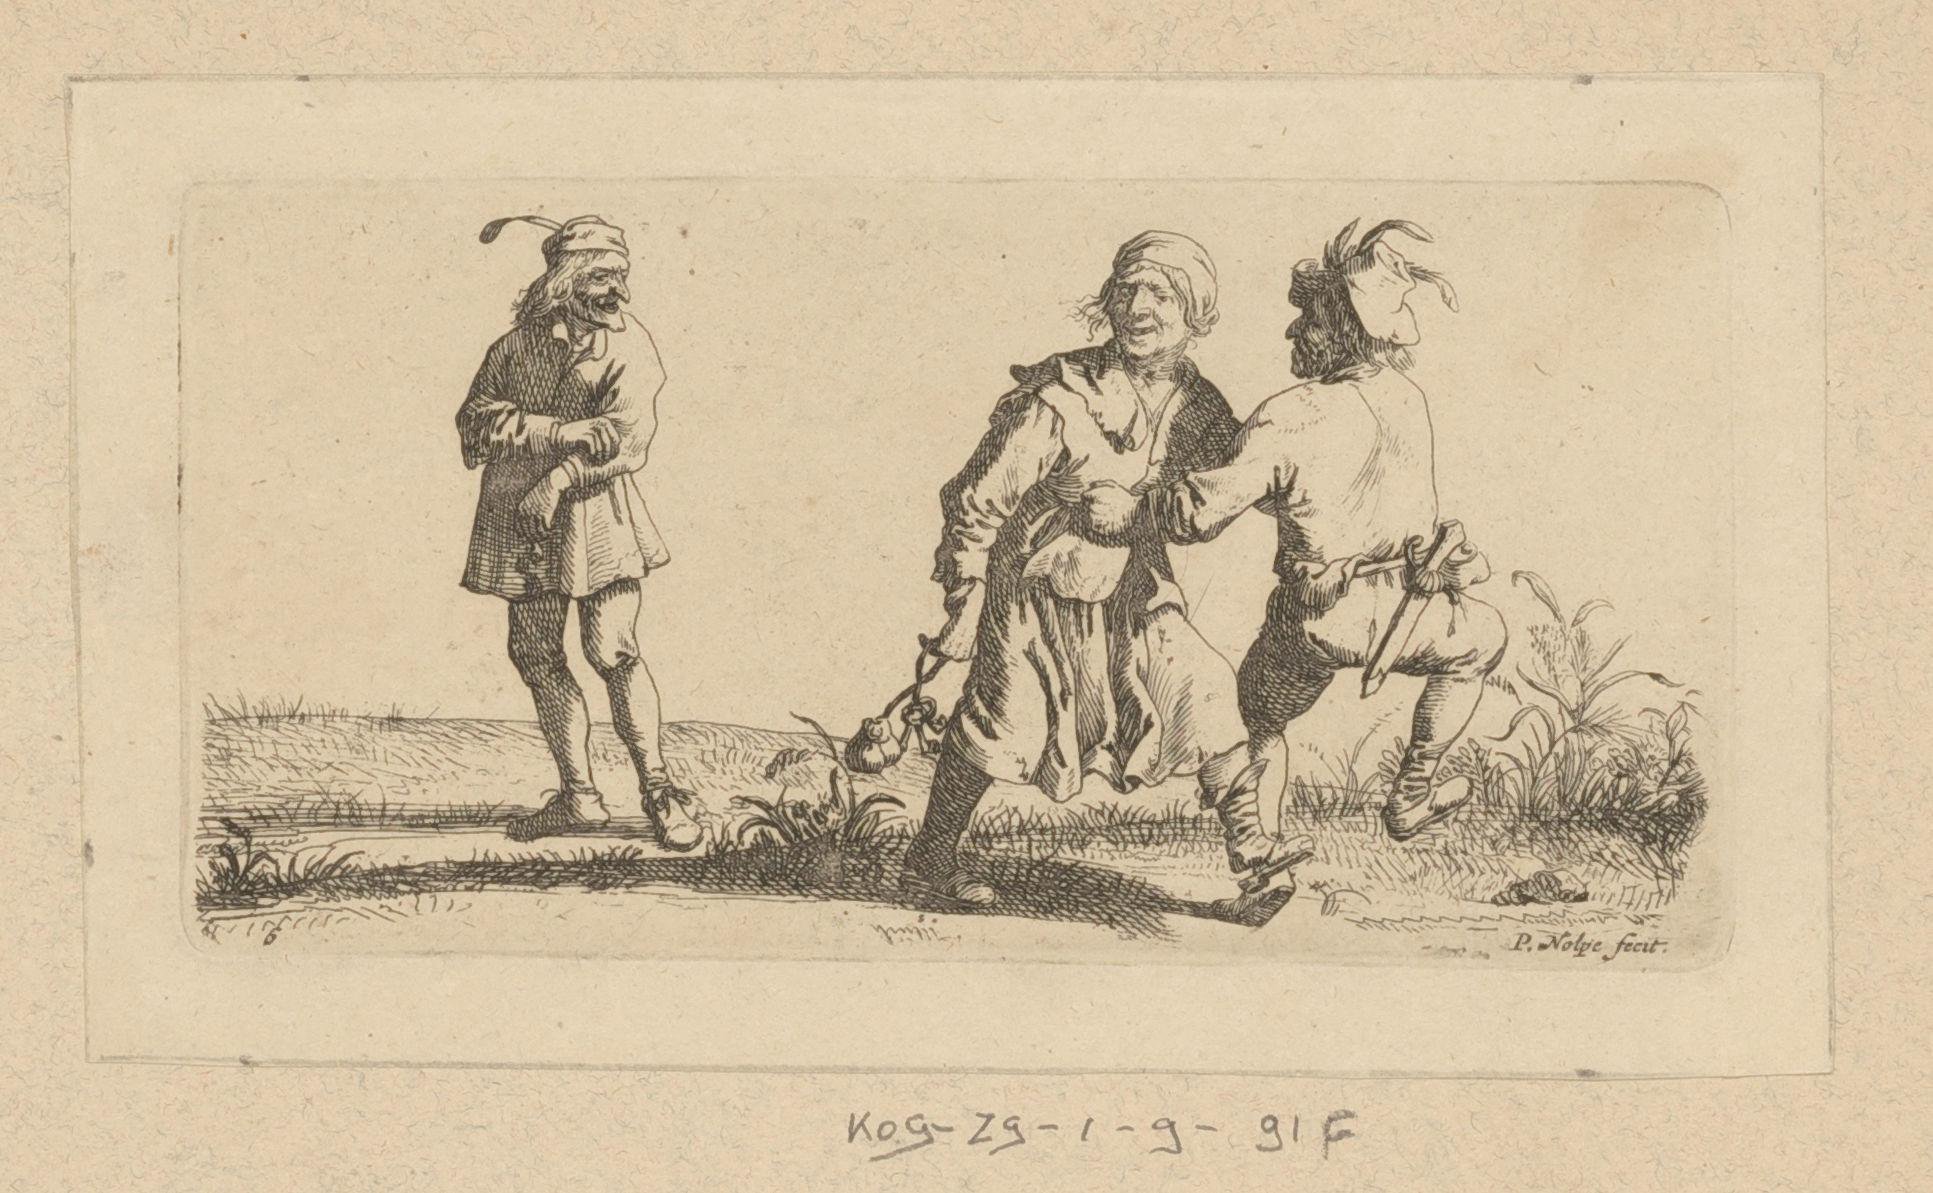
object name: print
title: Twee dansende boeren en een toeschouwer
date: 1633-1679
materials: paper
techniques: engraving, etching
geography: amsterdam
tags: farmers, folk dancing (men and women together)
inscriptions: collector's mark: Lugt 1641, collector's mark: Lugt 963, stamp:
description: Een boer en een boerin dansen met elkaar. De vrouw houdt in een hand een sleutelbos en een geldbuidel. De man heeft een dolk aan zijn riem hangen. Links kijkt een derde boer toe. Onderwerpsrubrieken binnen de Atlas Zeden en Gewoonten: Handel, nijverheid en verkeer, Boerenleven.